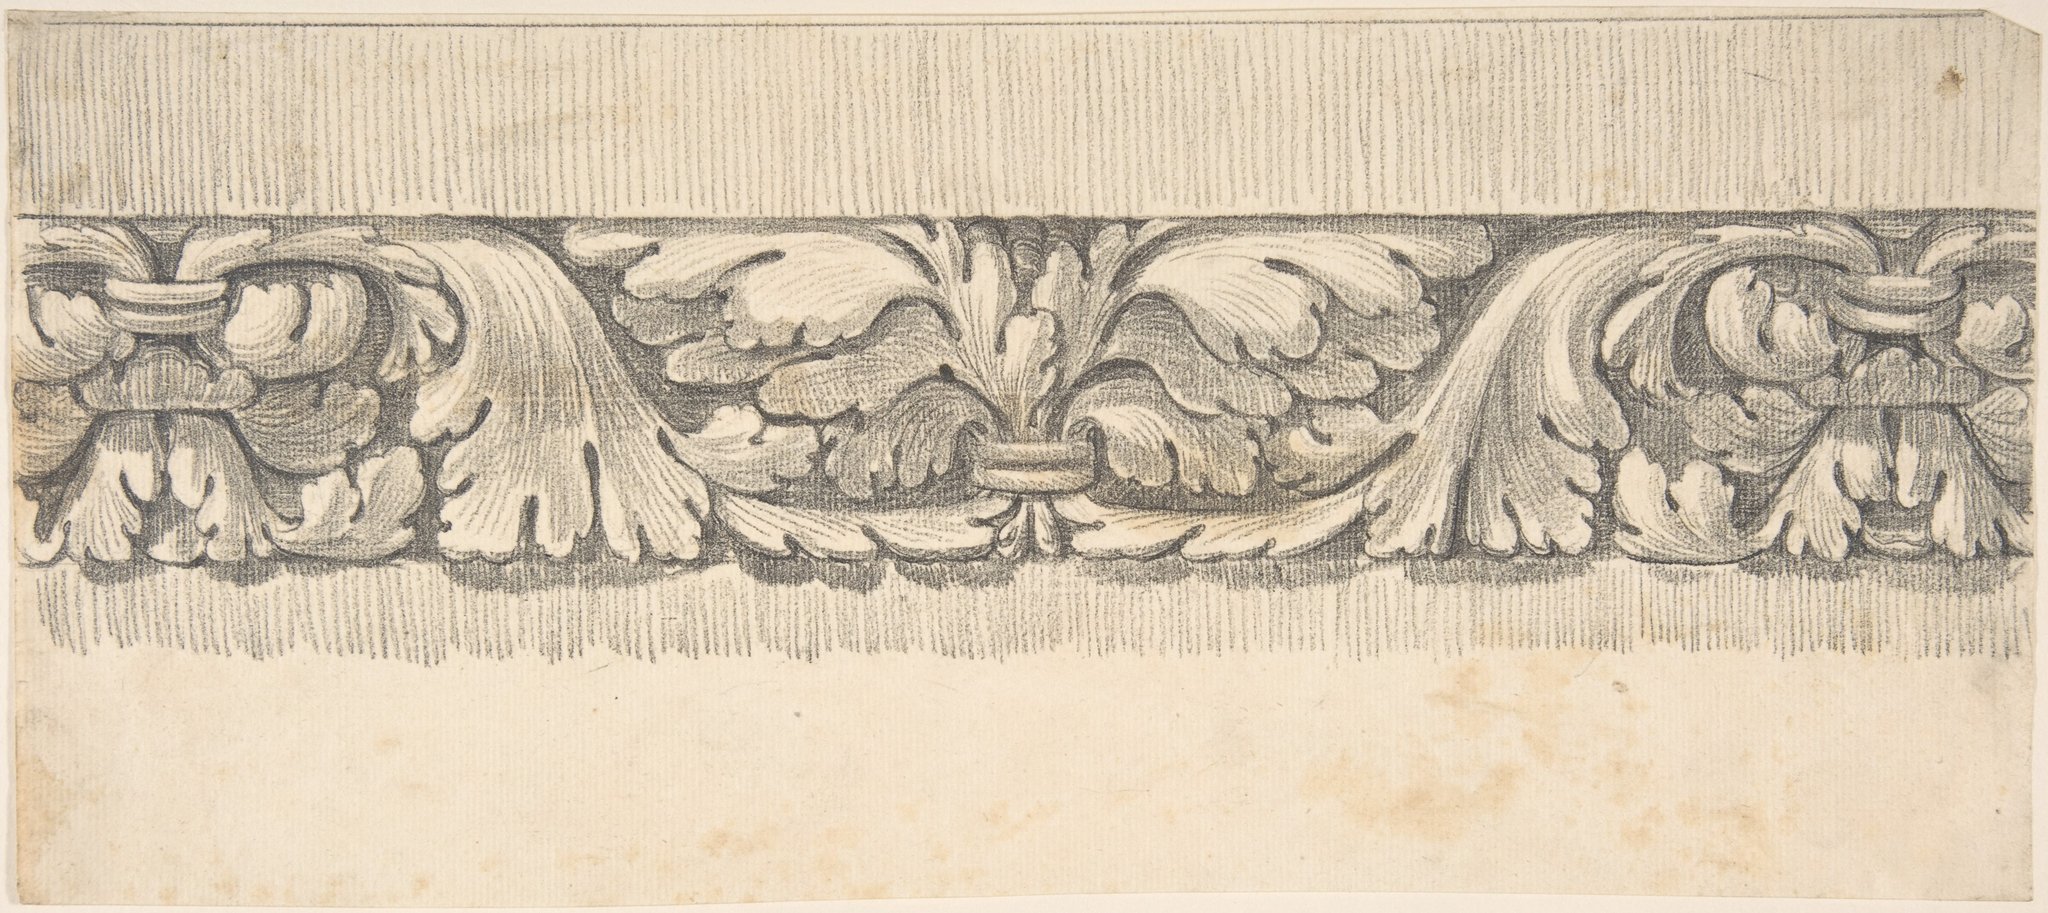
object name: drawing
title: Border Design from a Classical Frieze, Decorated with Vines and Leaves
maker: thomas hardwick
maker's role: artist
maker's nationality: british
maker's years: 1752-1829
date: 1776-1779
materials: graphite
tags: leaves